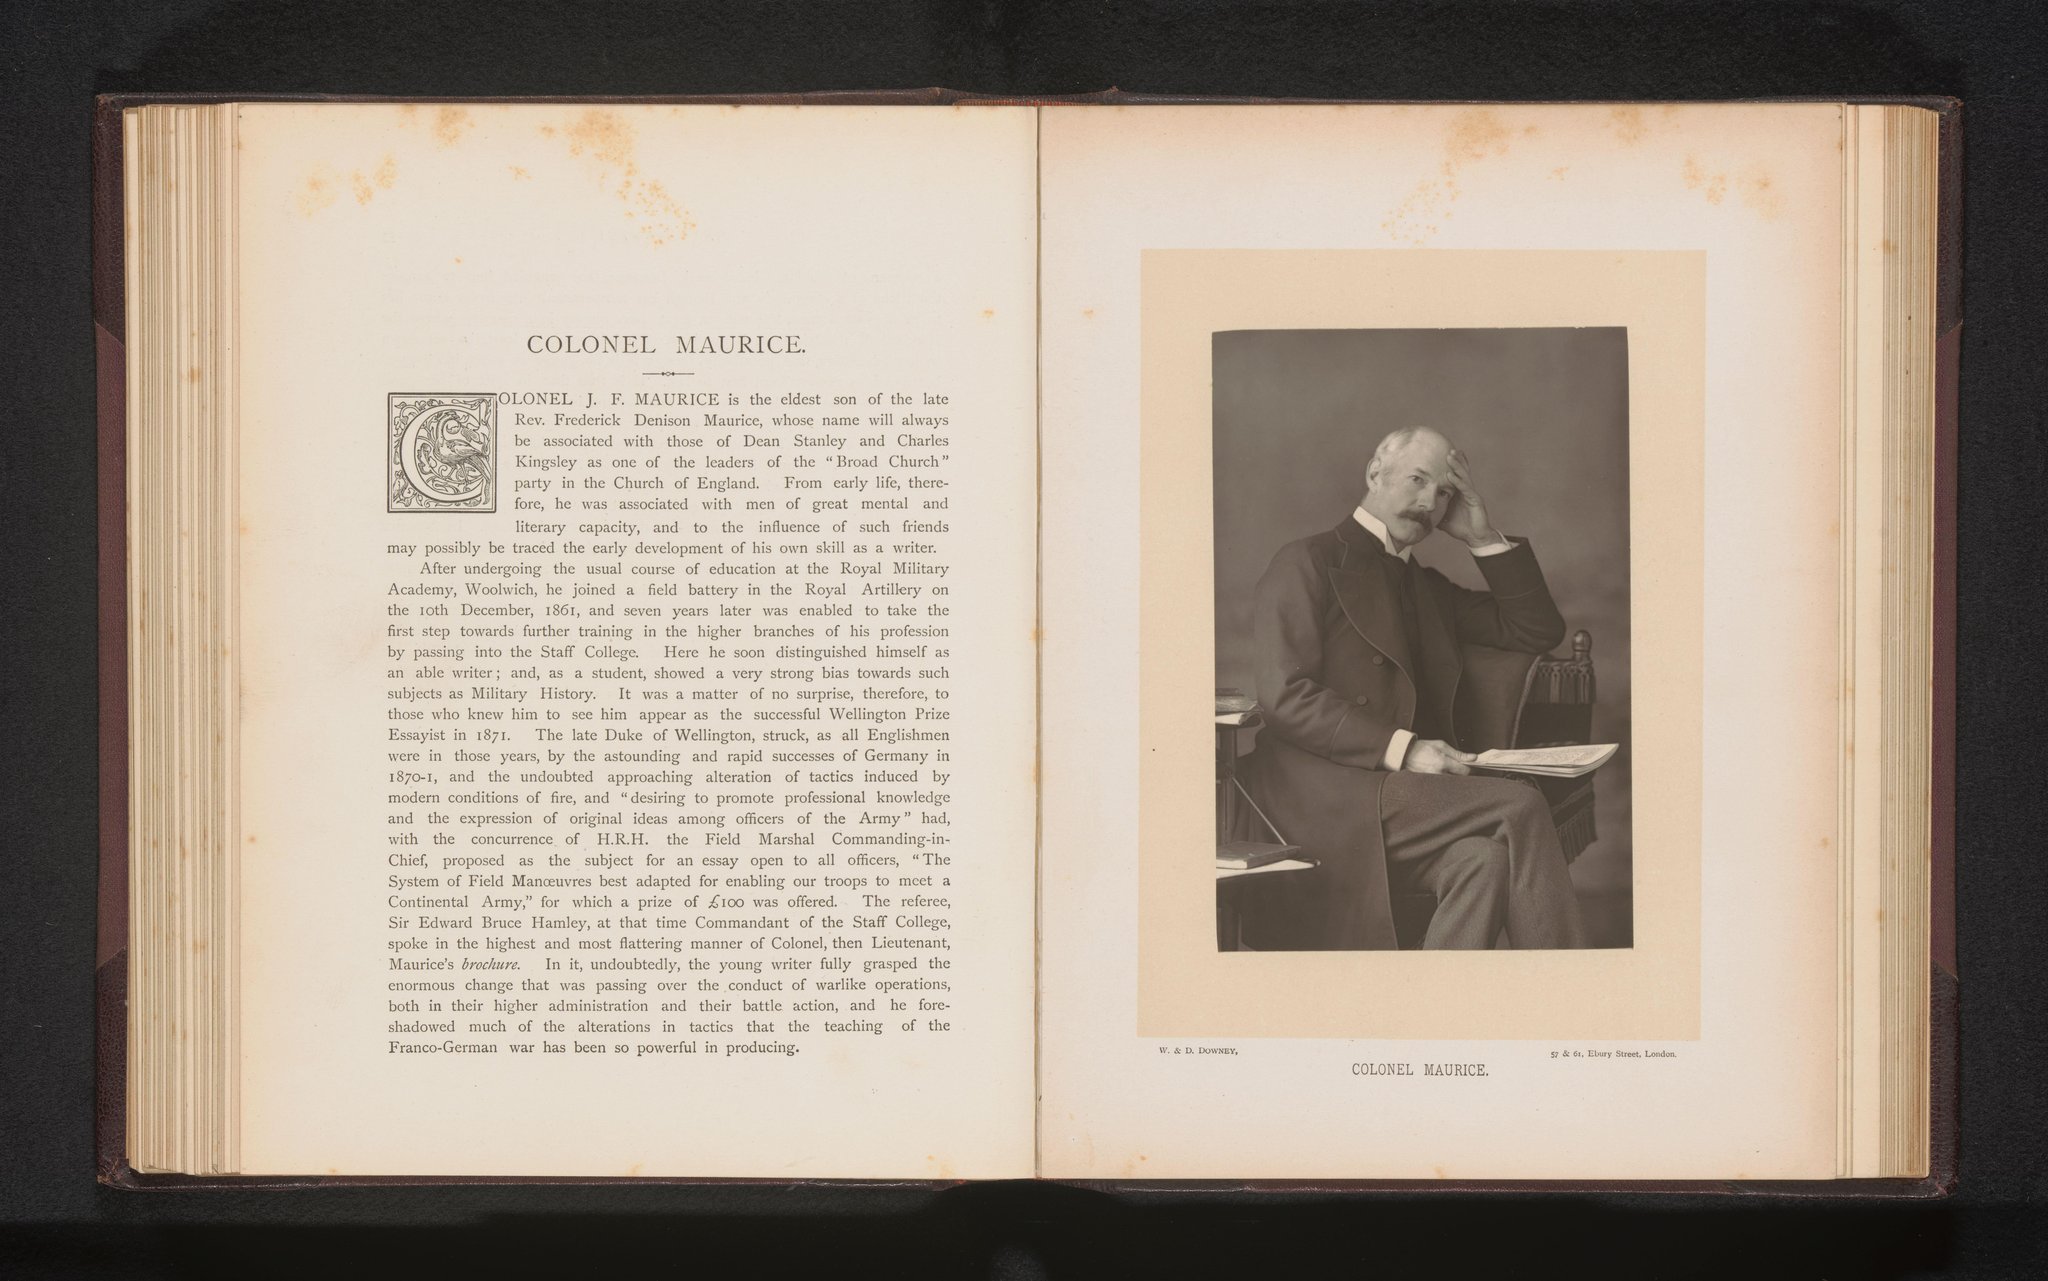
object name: photograph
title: Colonel Maurice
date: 1885-1890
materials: paper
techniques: carbon print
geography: london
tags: historical persons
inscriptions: address: ‘57 & 61, Ebury Street, London.’